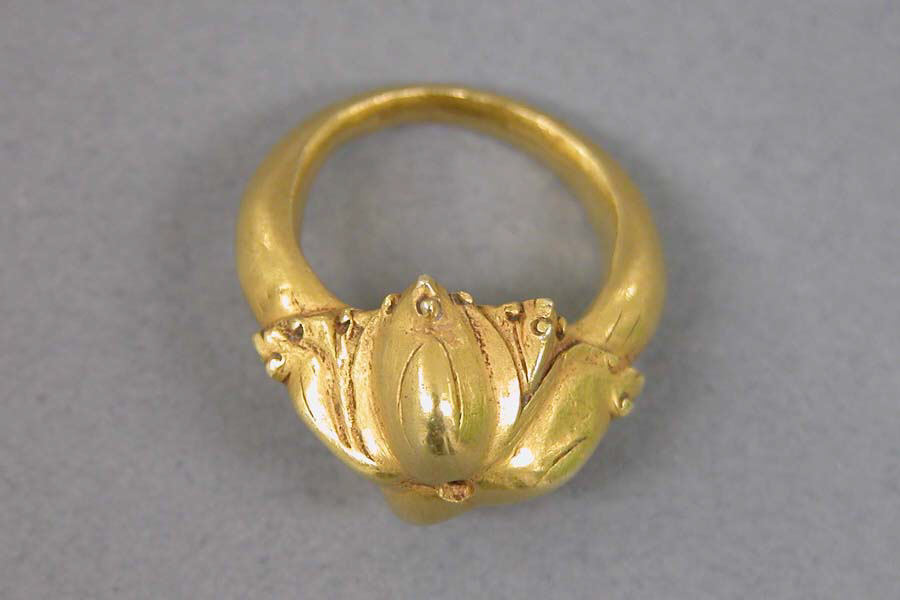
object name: ring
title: Ring with Lotus Motif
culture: indonesian, javanese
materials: gold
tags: lotuses